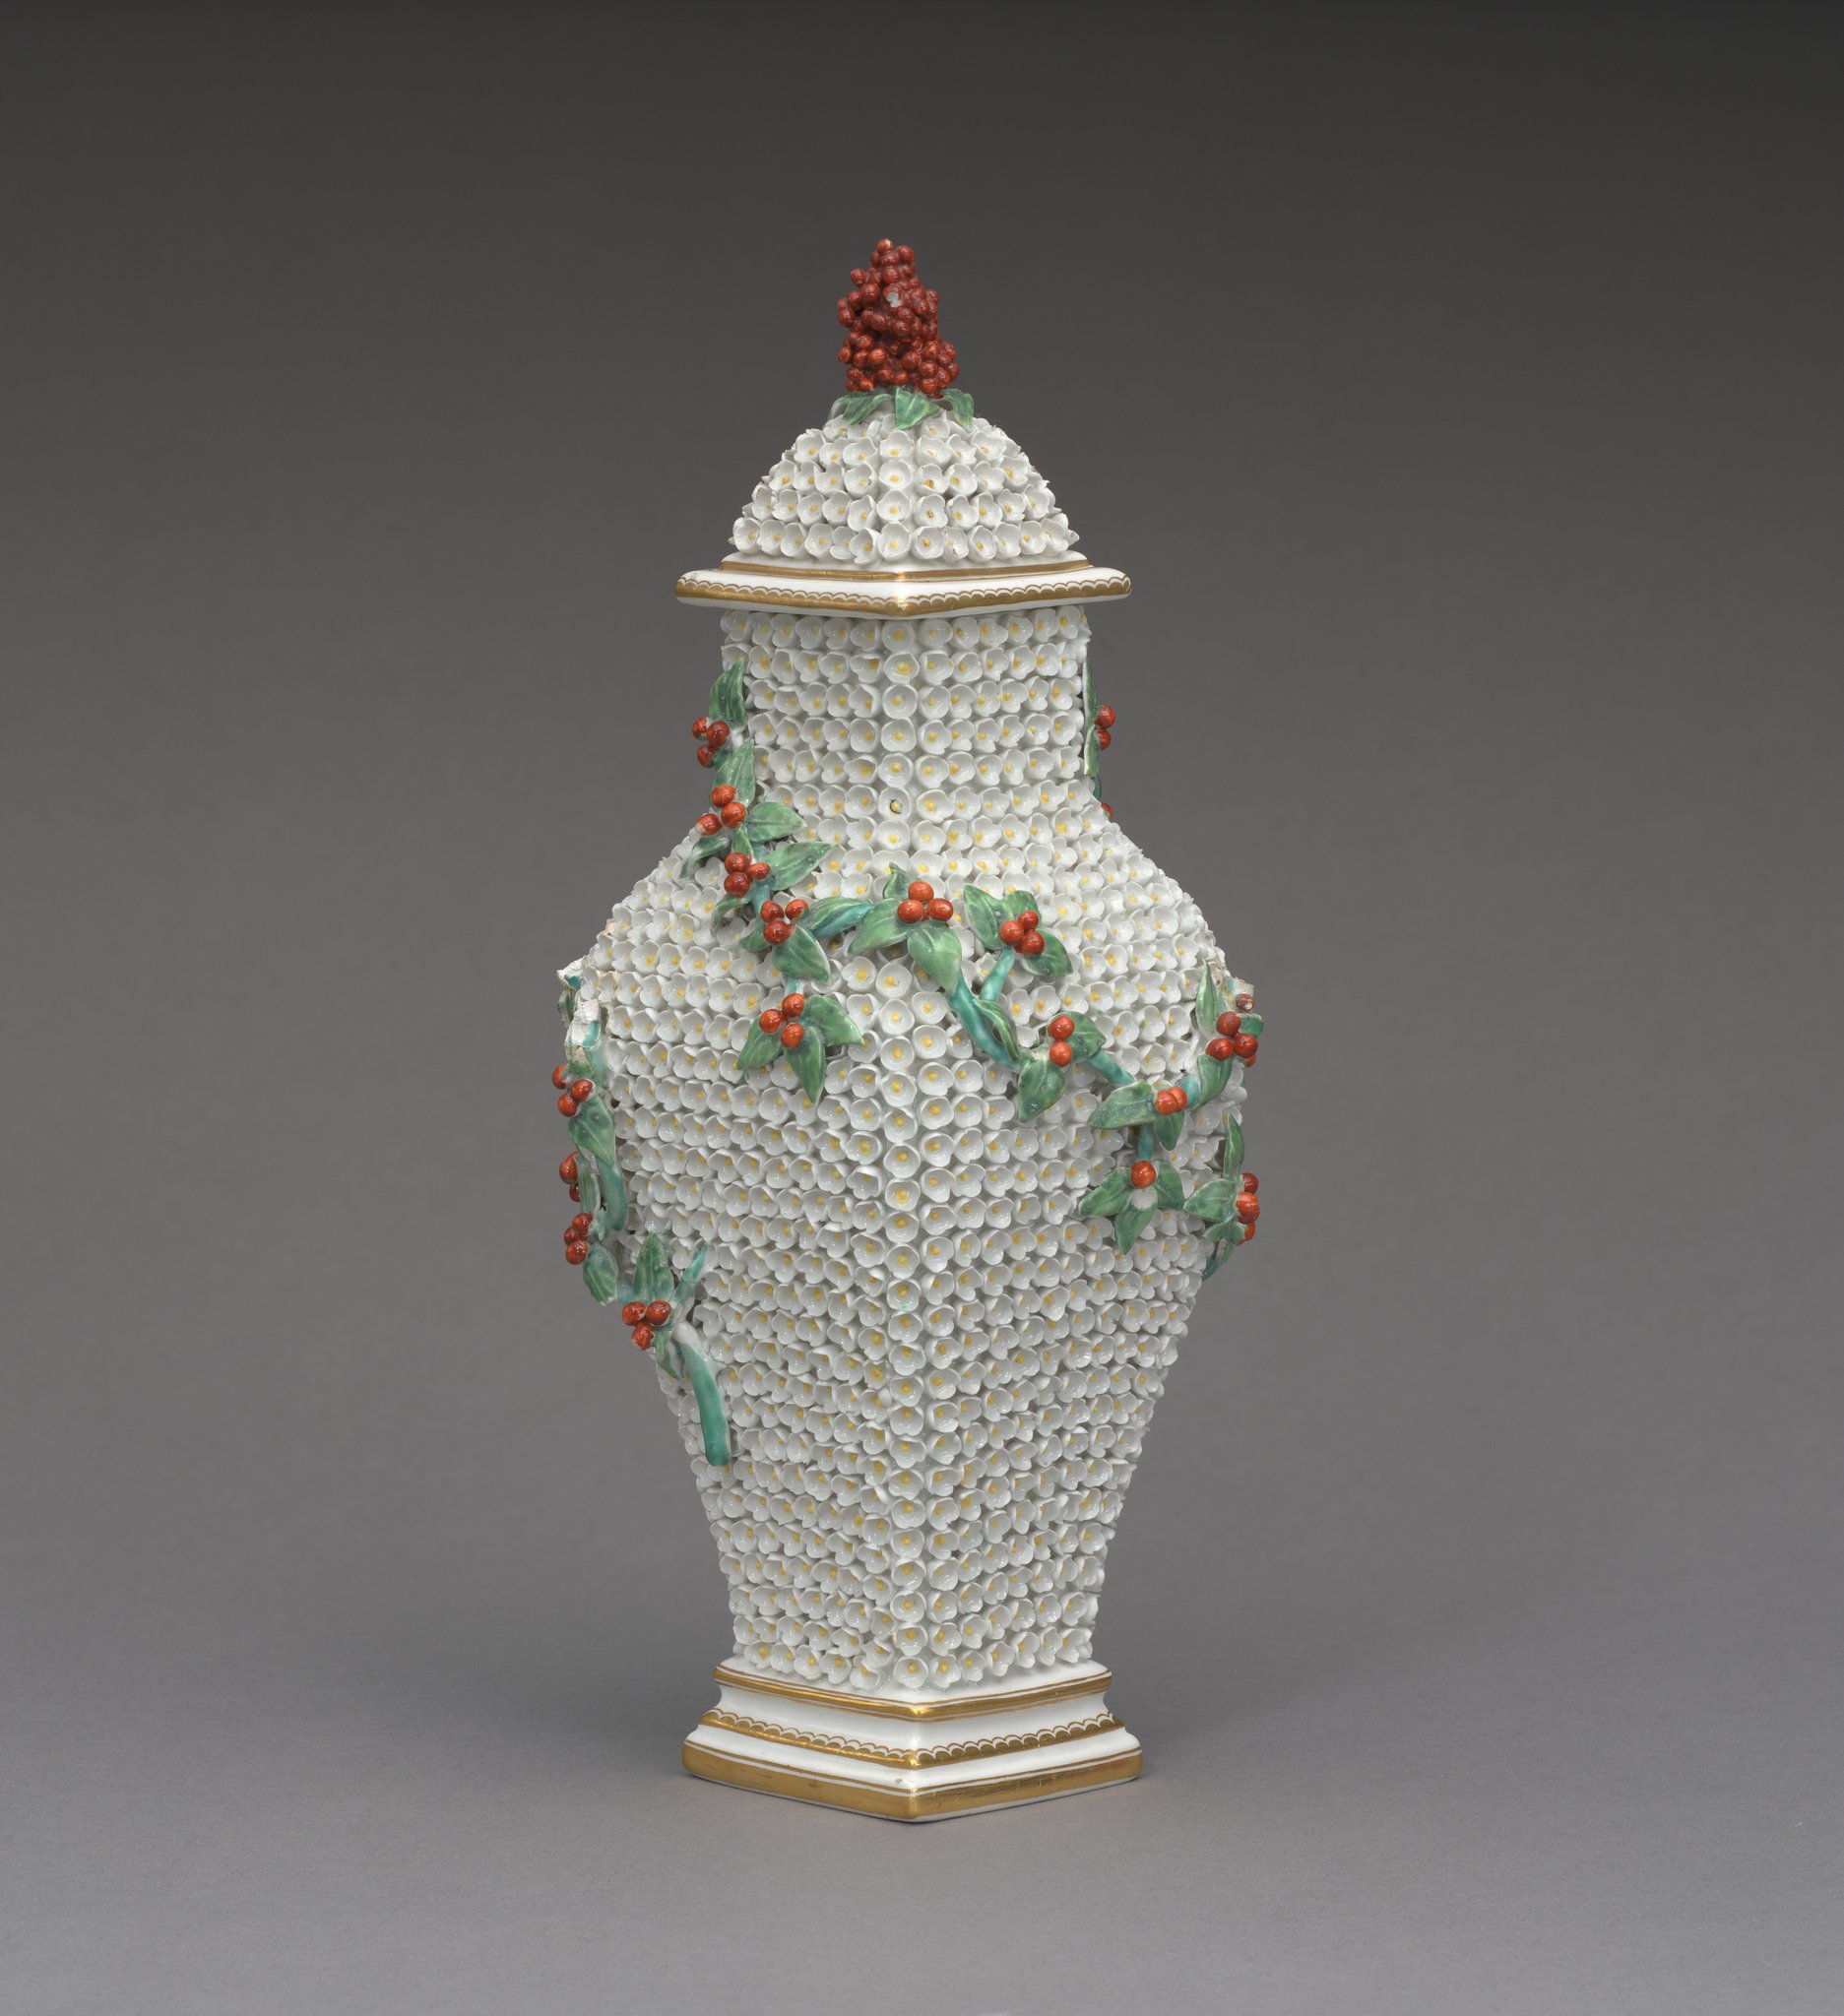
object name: vase with cover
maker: chelsea porcelain manufactory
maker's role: factory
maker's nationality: british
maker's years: 1744-1784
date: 1765-1775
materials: soft paste porcelain